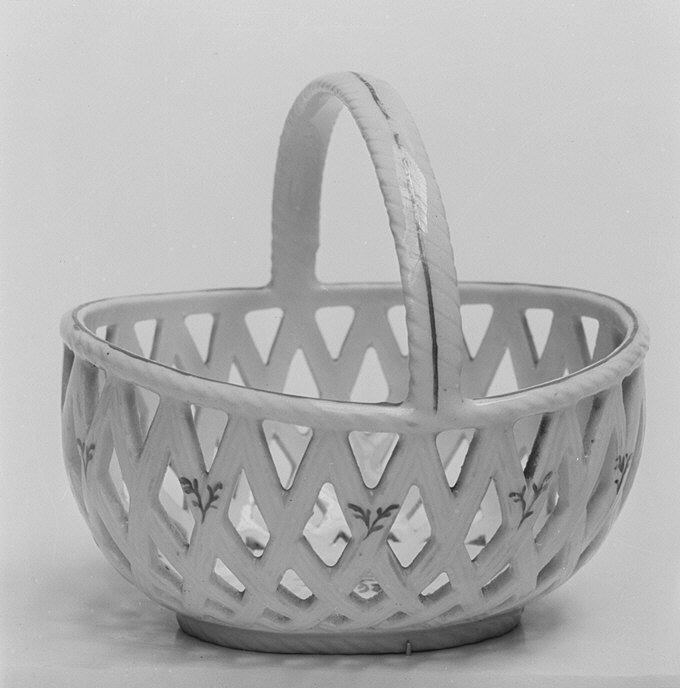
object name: basket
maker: loosdrecht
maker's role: factory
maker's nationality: dutch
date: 1780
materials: hard paste porcelain